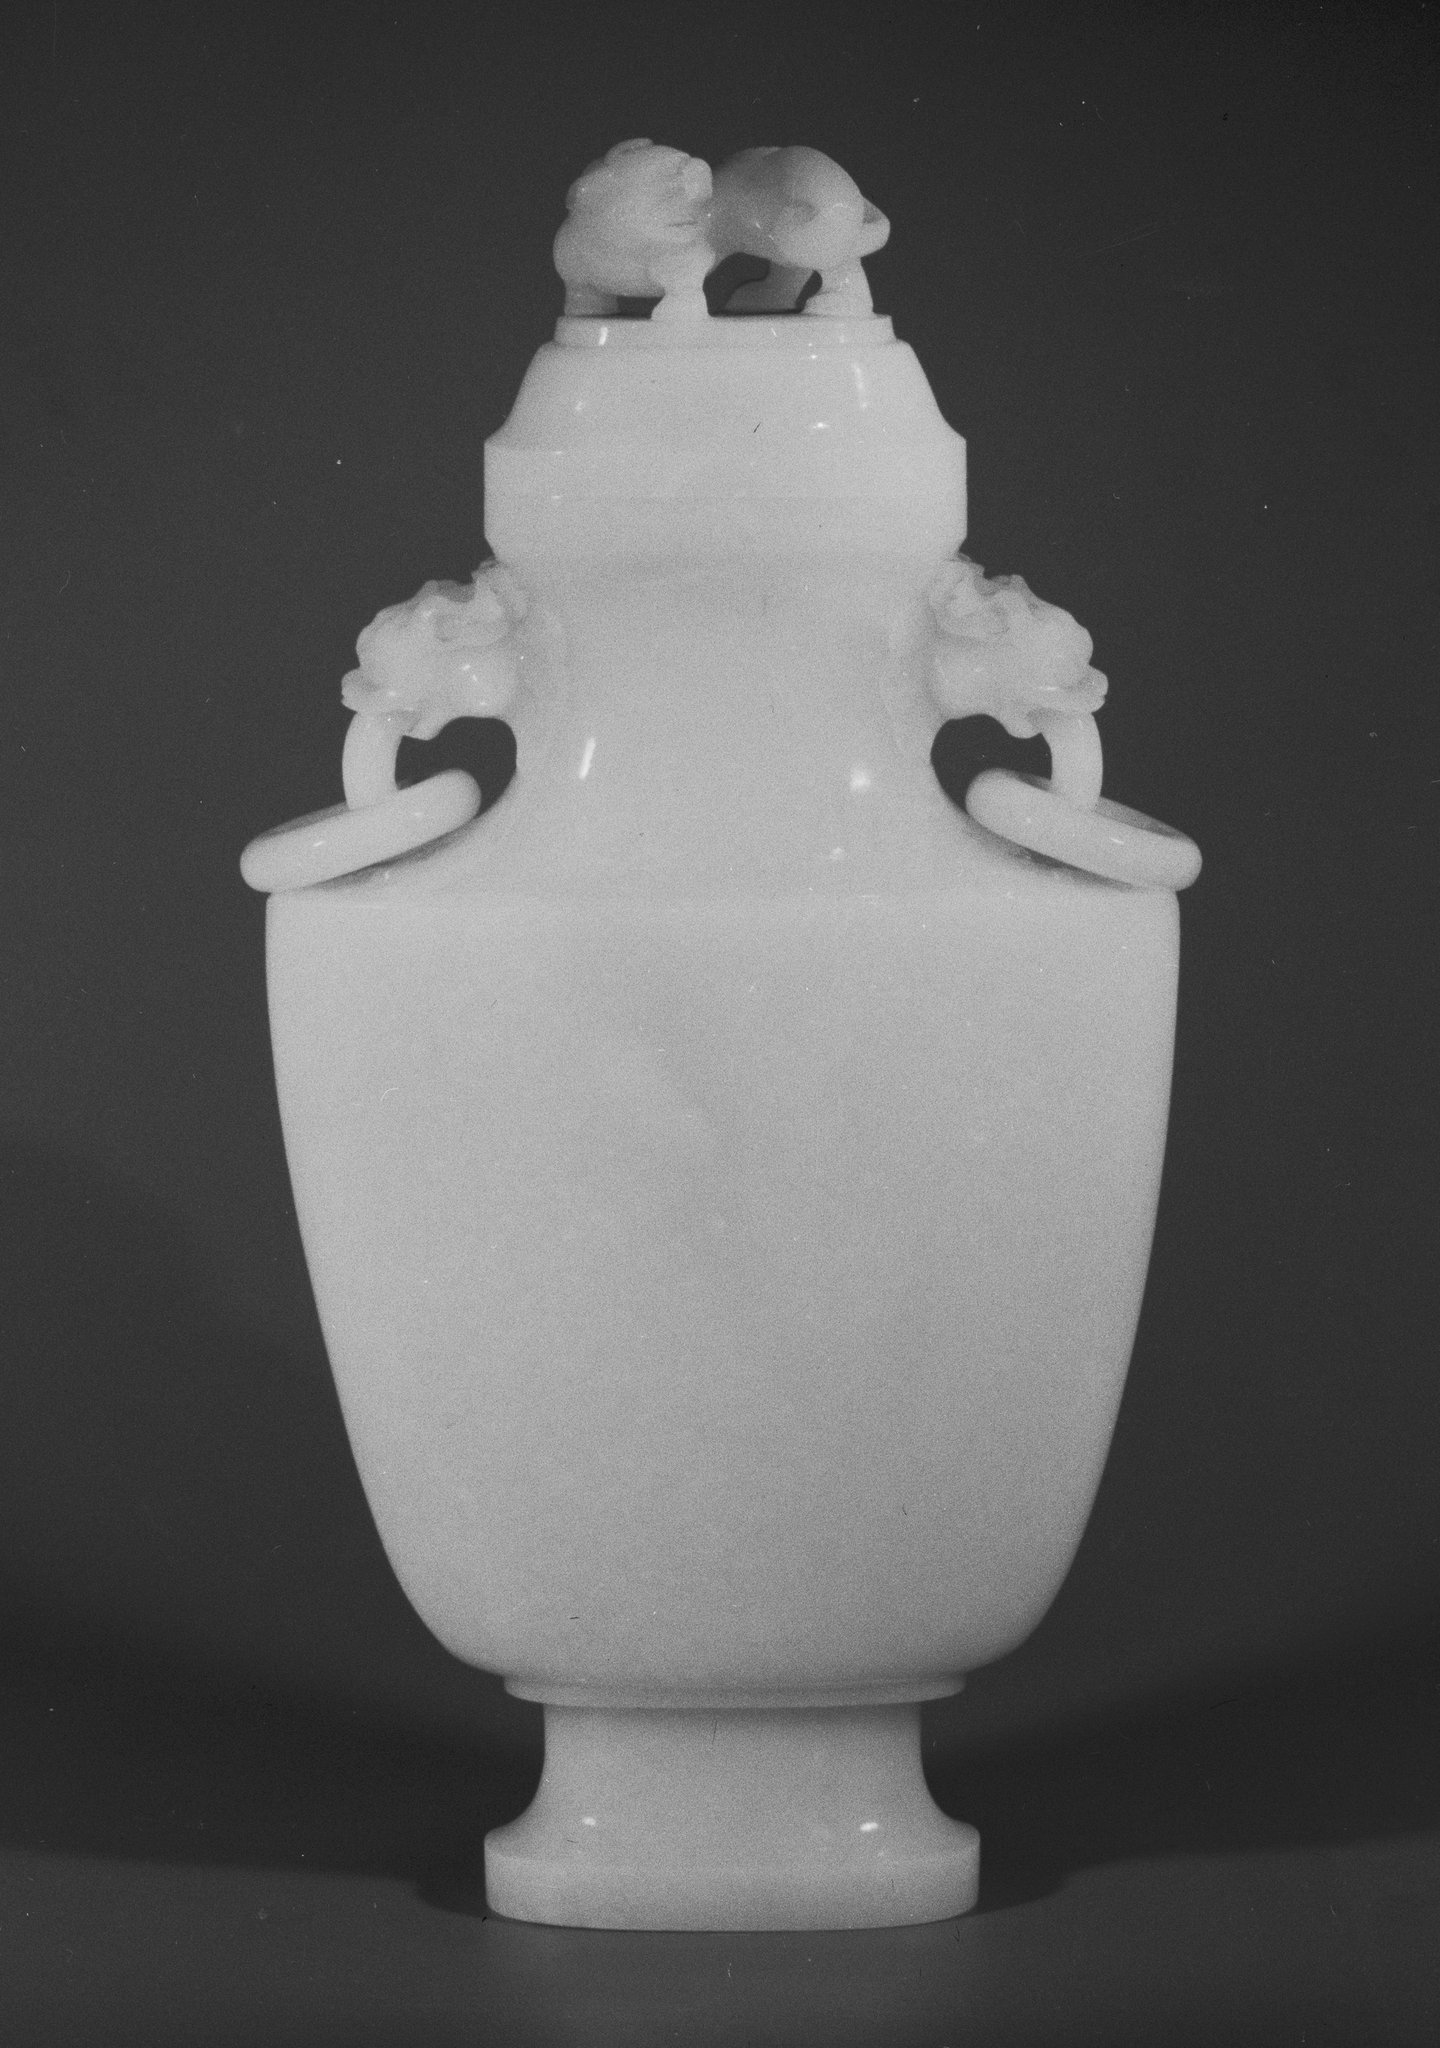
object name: covered vase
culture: chinese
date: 1701-1800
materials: jade